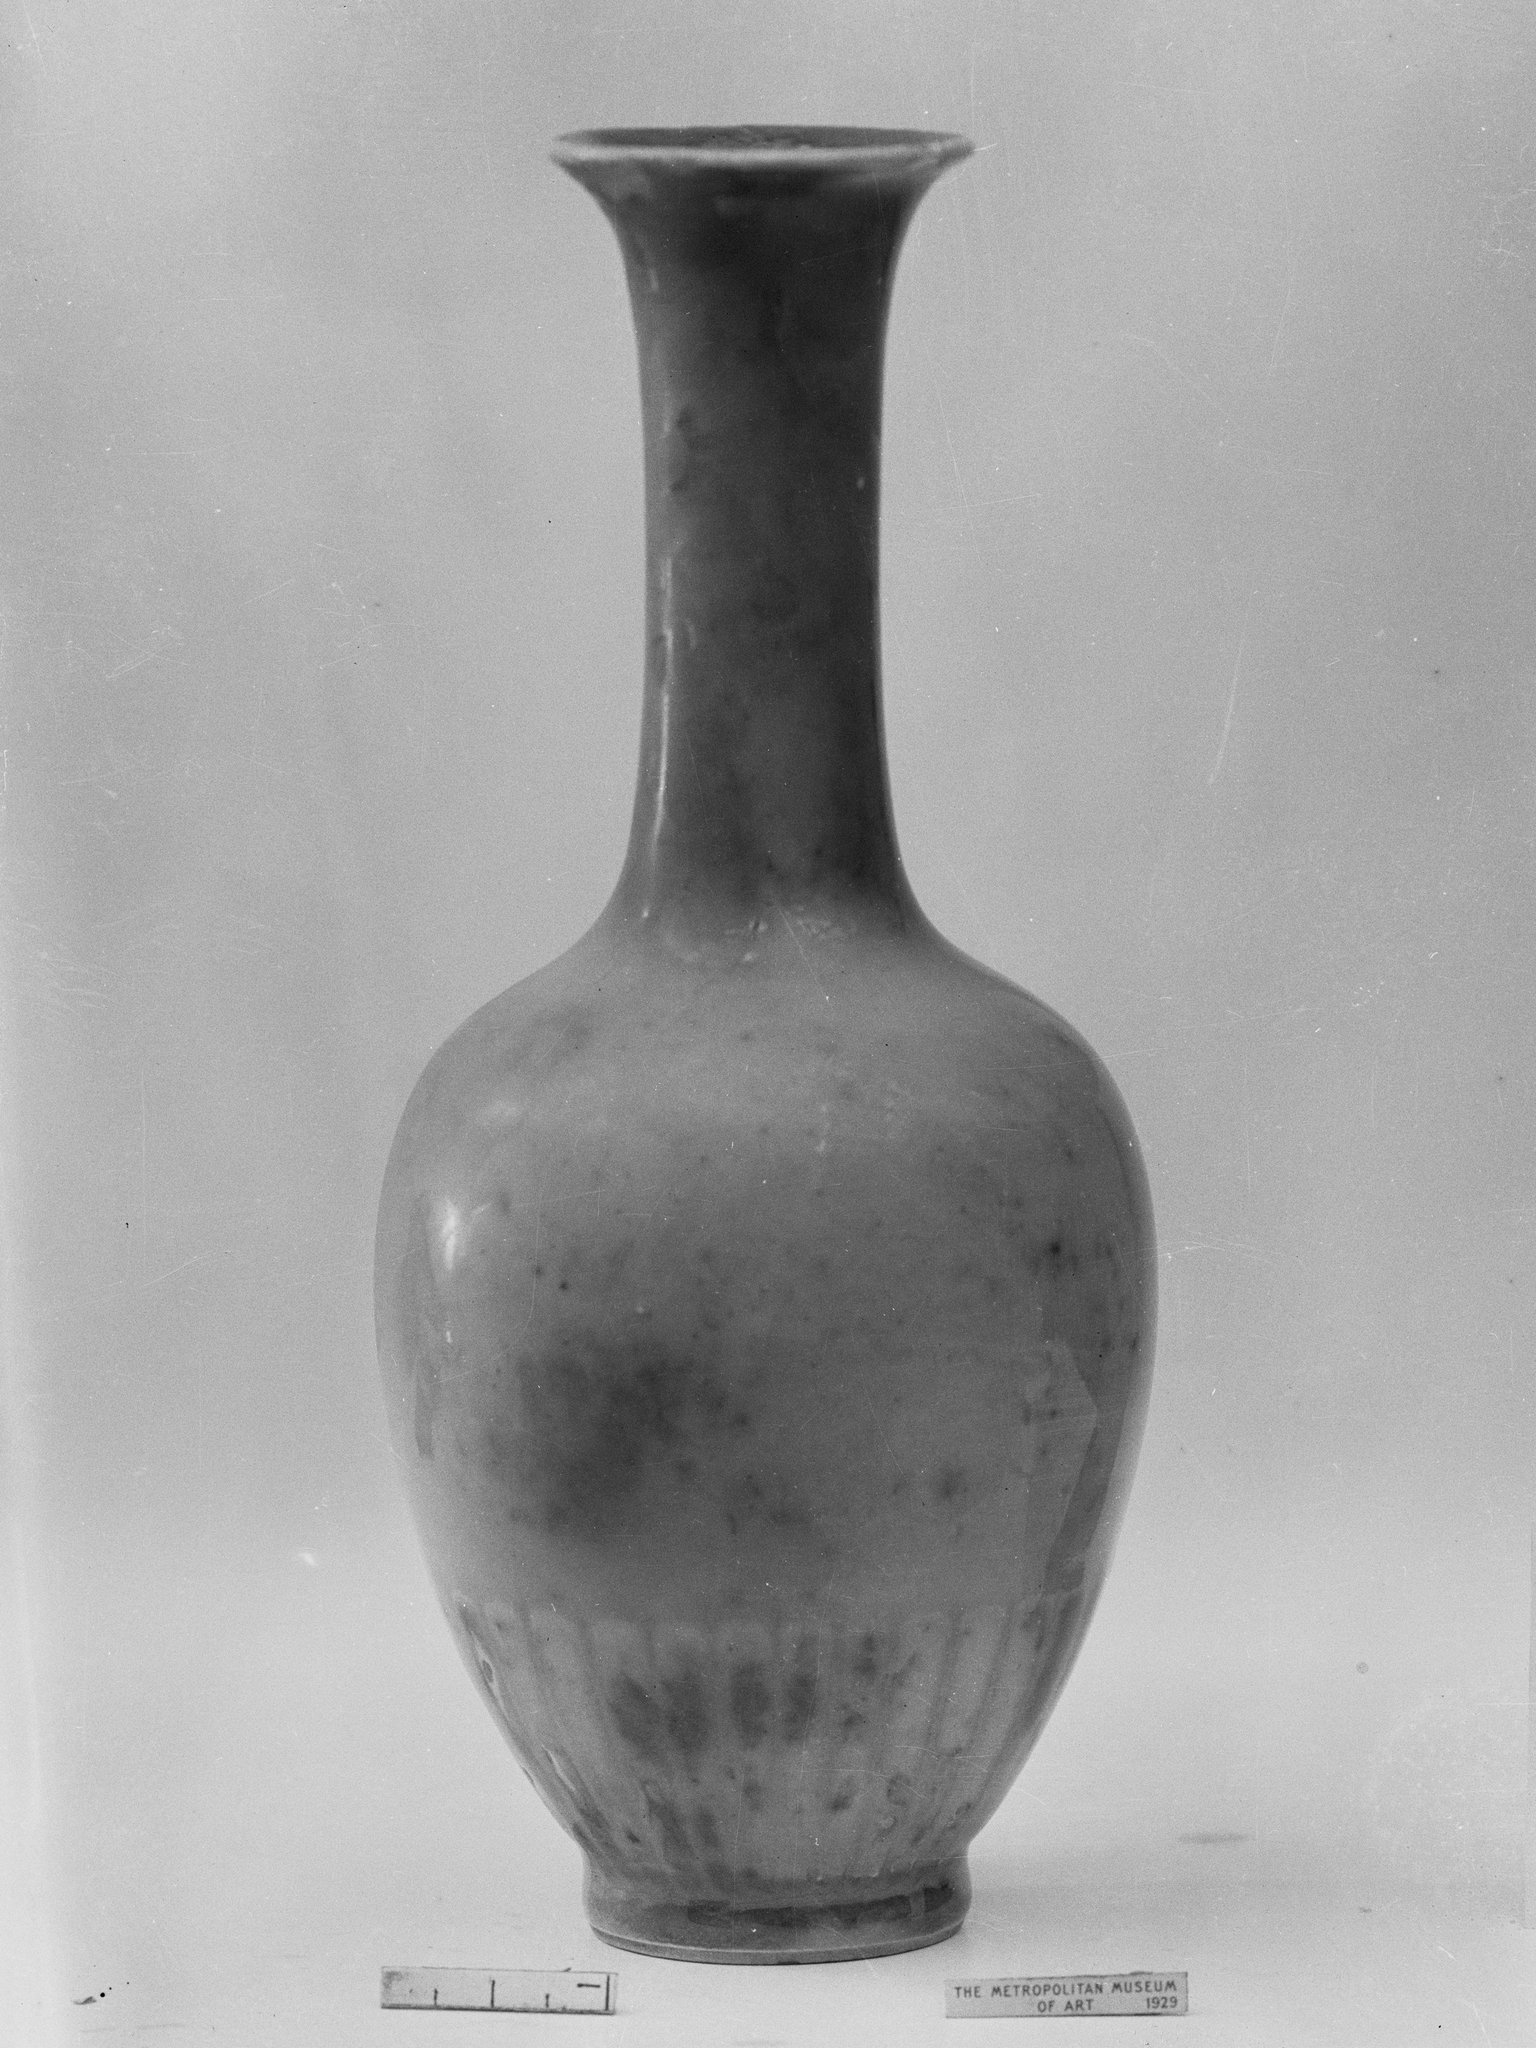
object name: bottle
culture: chinese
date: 1662-1722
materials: glaze, porcelain